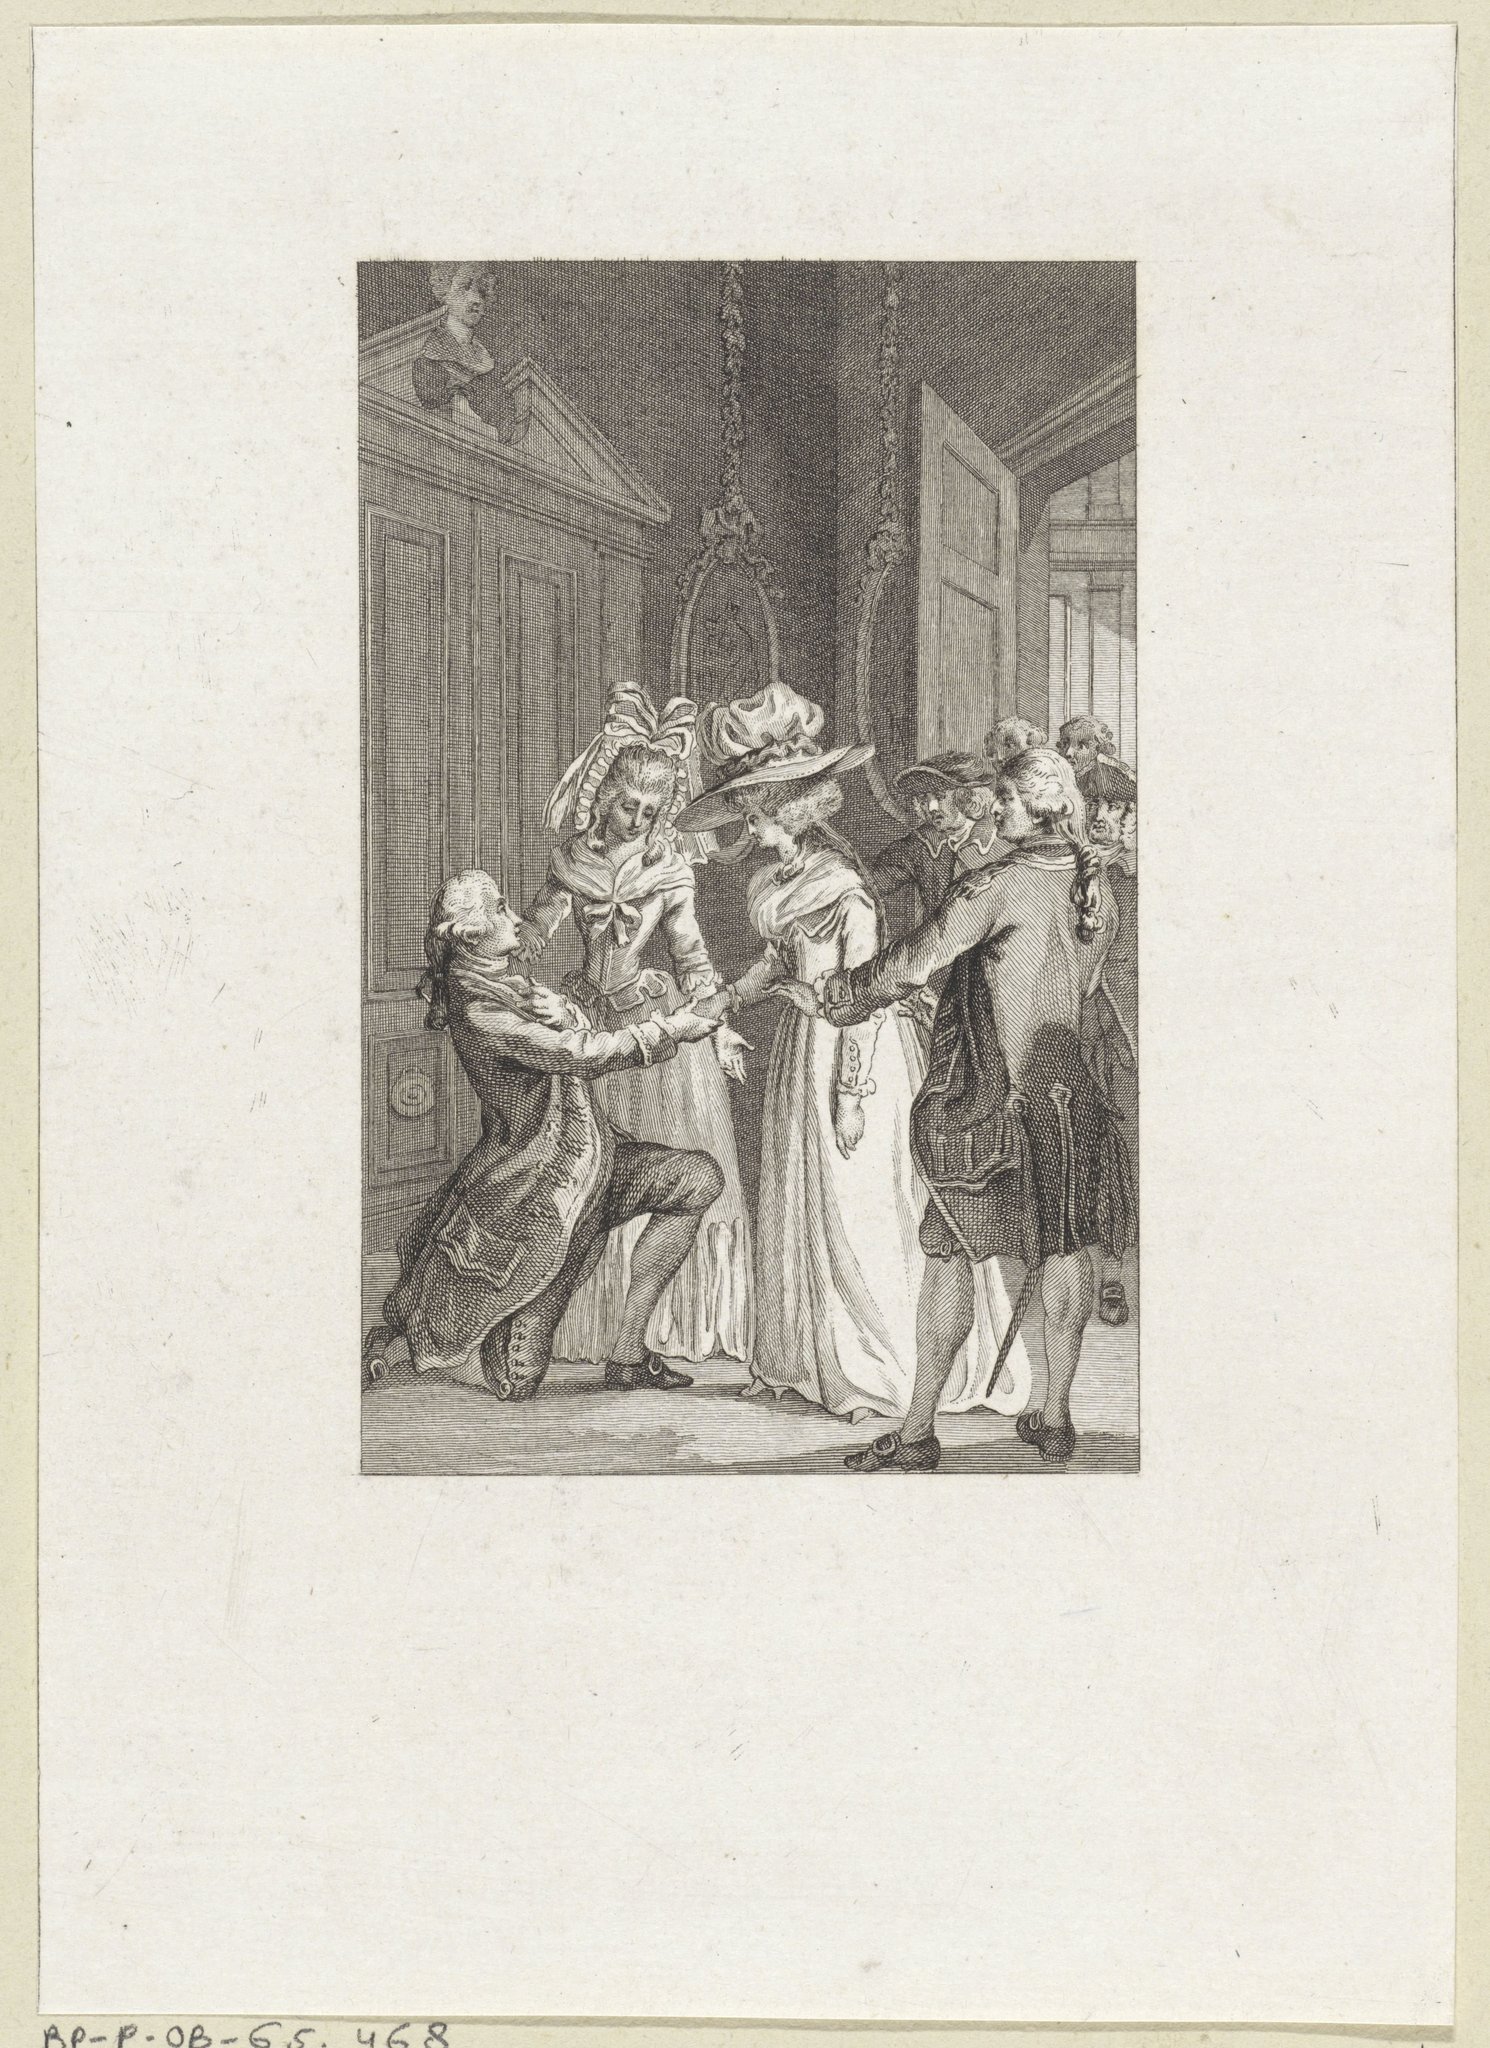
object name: print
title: Man knielt voor een dame, genaamd Sophie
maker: reinier vinkeles (i)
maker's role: draughtsman, print maker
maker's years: 1741-1816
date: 1789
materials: paper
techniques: engraving, etching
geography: amsterdam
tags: man kneeling before his beloved (proposing)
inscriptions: collector's mark: Lugt 240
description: Proefdruk van een prent die mogelijk ook gebruikt is als illustratie in: Fielding, Henry. Tom Jones en Fellamar. Amsterdam: erven van Pieter Meĳer en Gerrit Warnars, 1789.